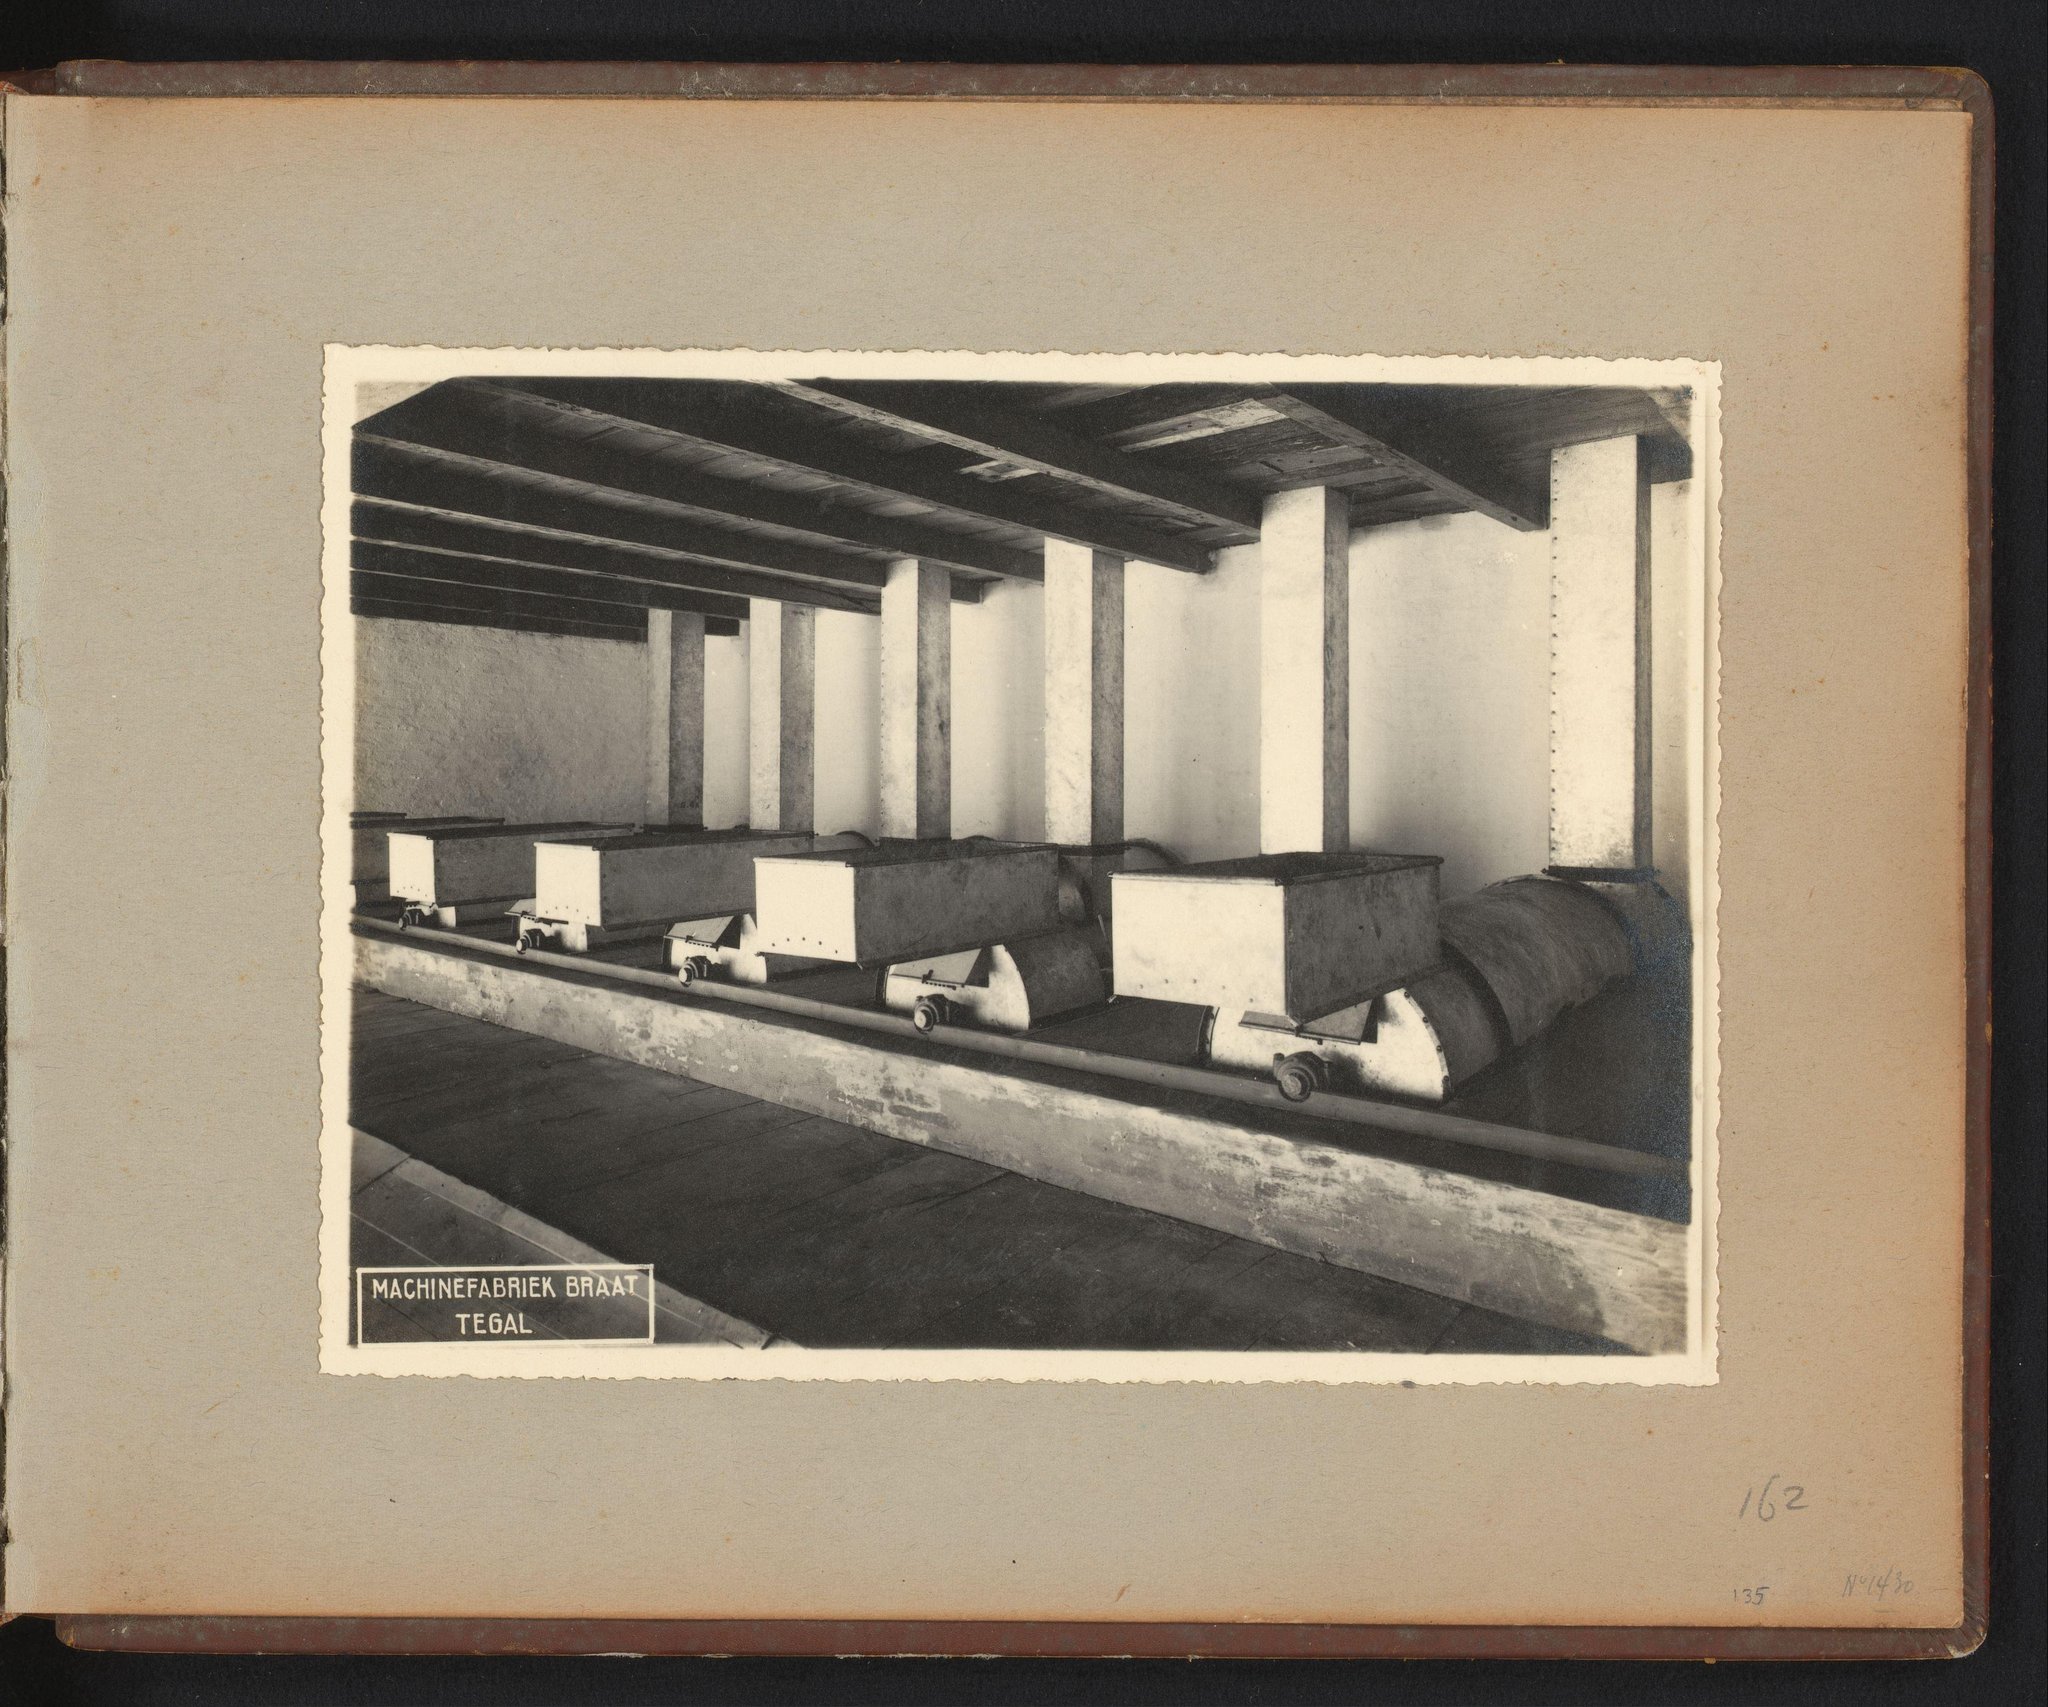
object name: photograph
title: Installatie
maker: Anonymous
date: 1931-1937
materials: cardboard, photographic support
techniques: gelatin silver print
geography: tegal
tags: factory-interior, machine shop, machines; parts of machines; tools and appliances, java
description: Albumblad met een foto van een installatie ingericht door Braat Tegal. Onderdeel van een fotoalbum met foto's van machines en constructies van de N.V. Machinefabriek Braat te Soerabaja, Soekaboemi en Tegal uit de periode 1931-1937.